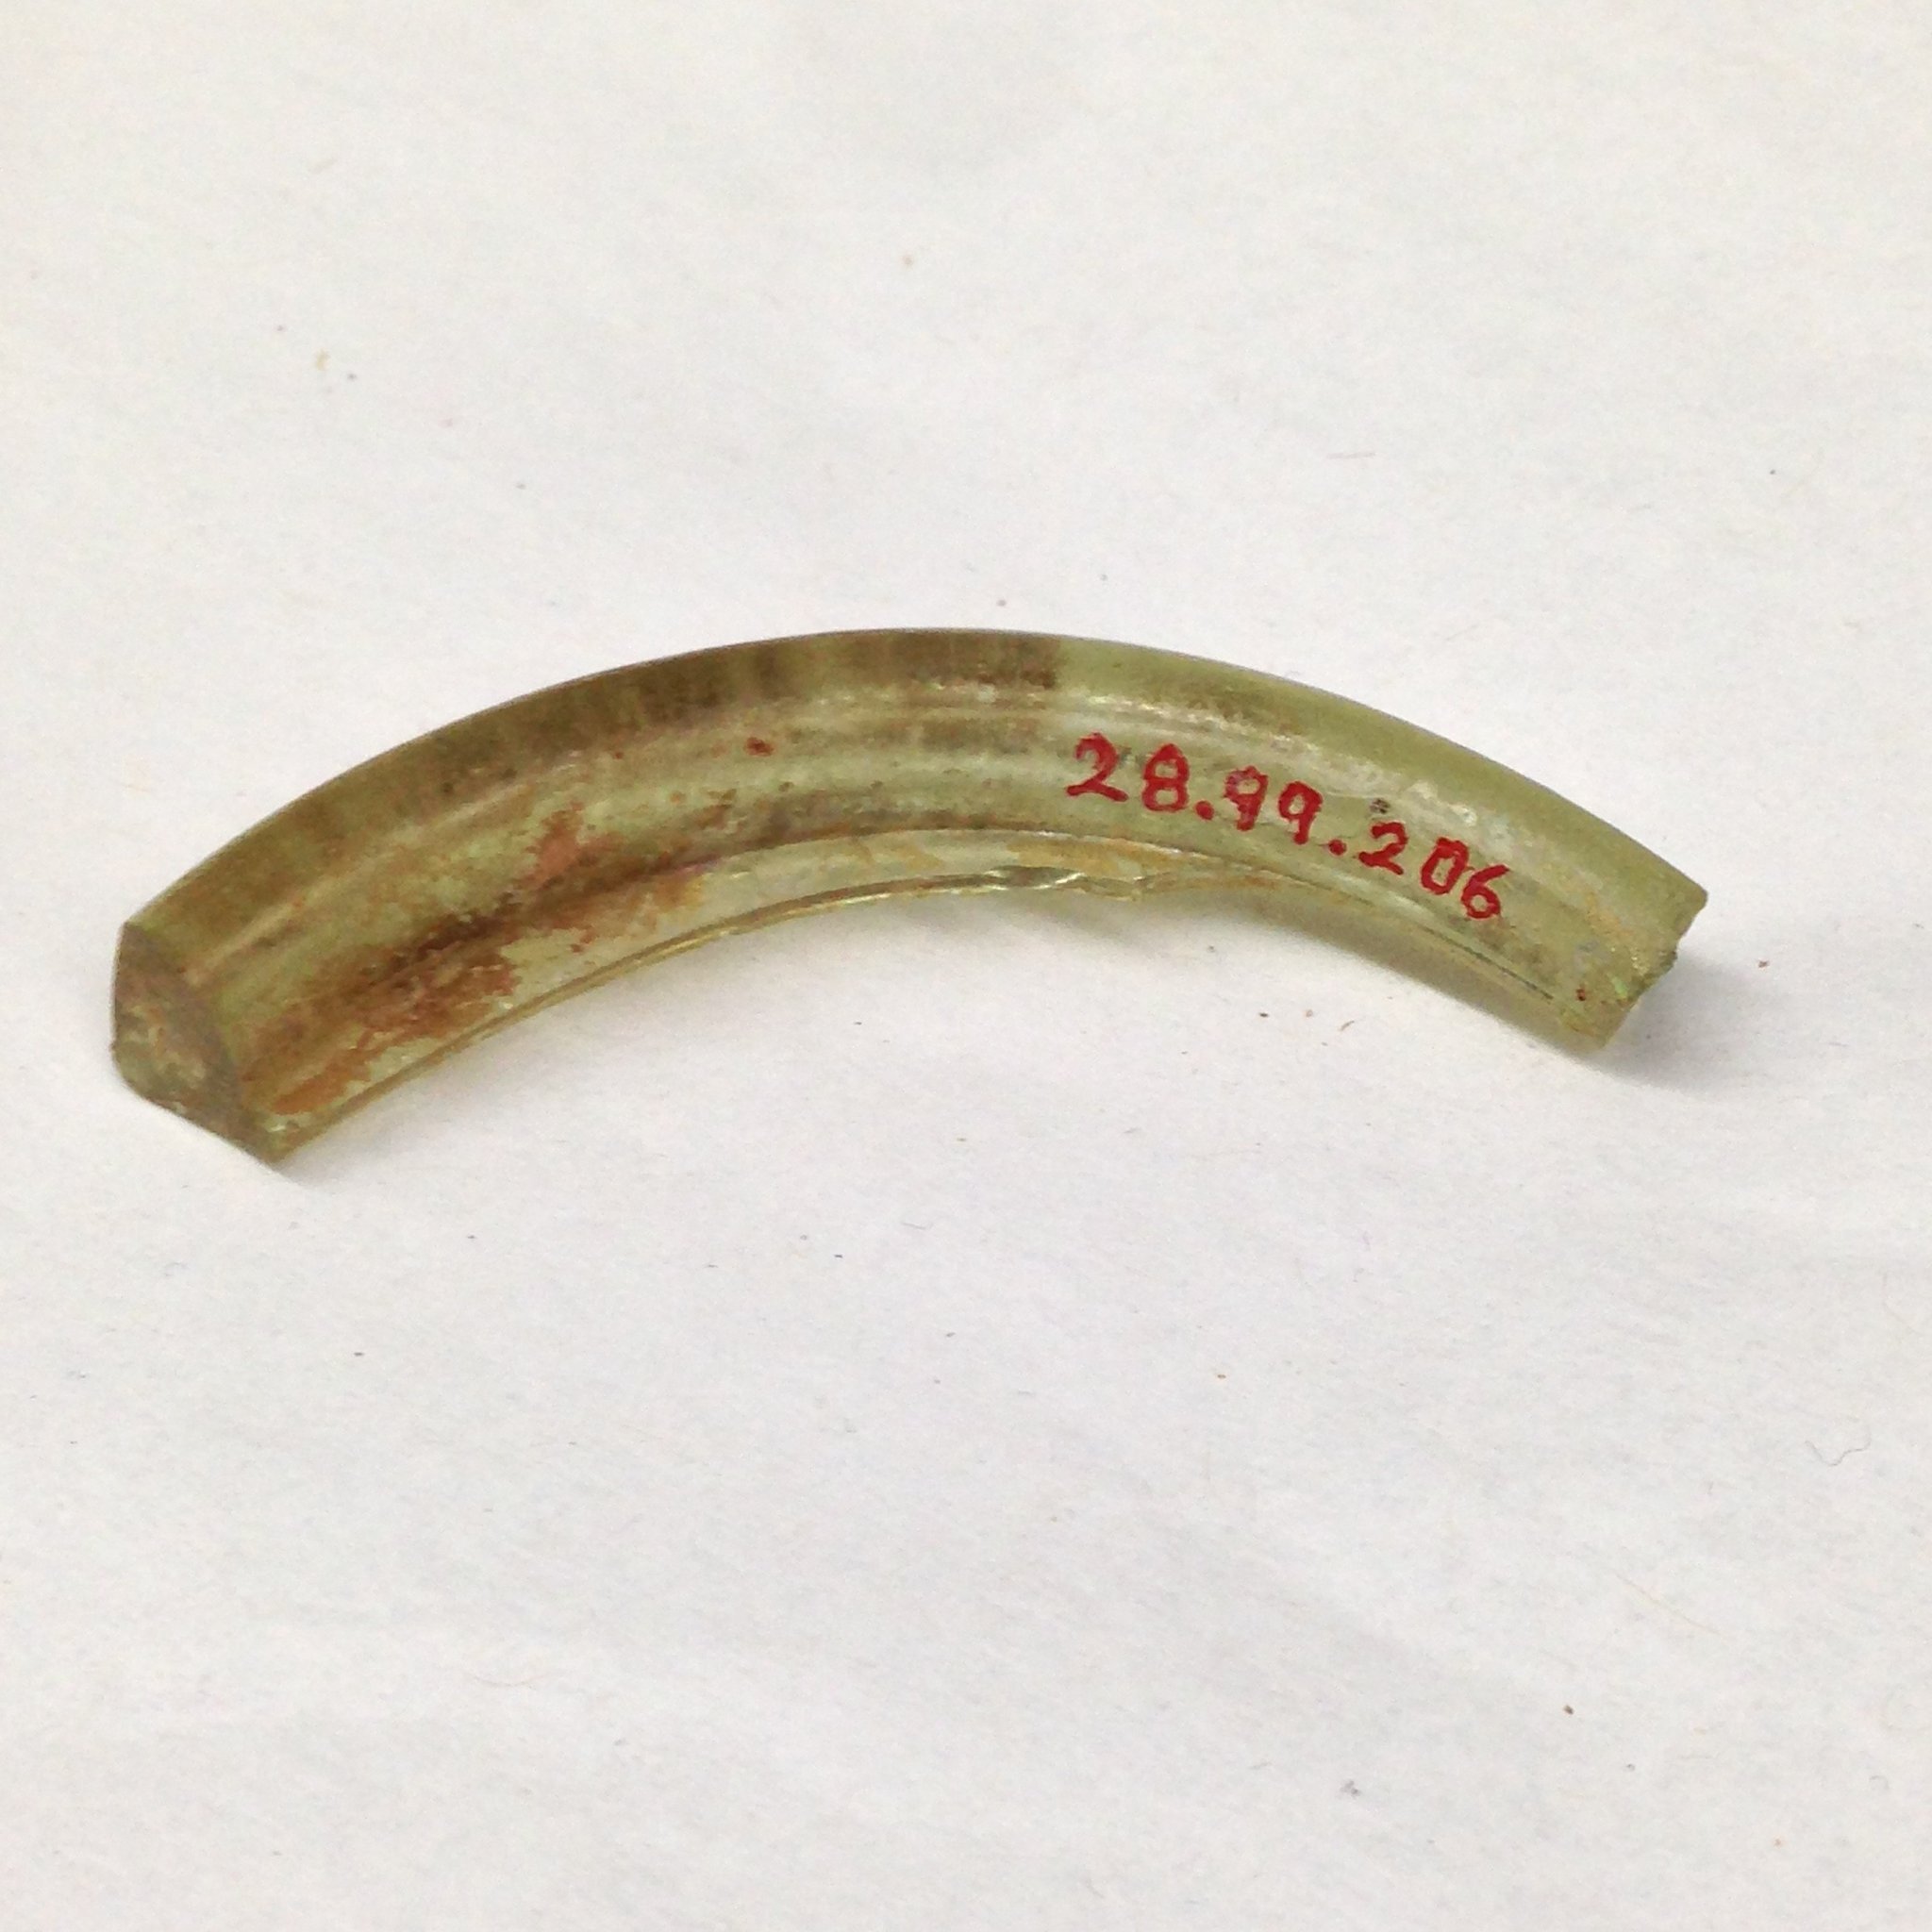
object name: fragment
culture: european or middle eastern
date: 1150-1250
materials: ceramic, glass